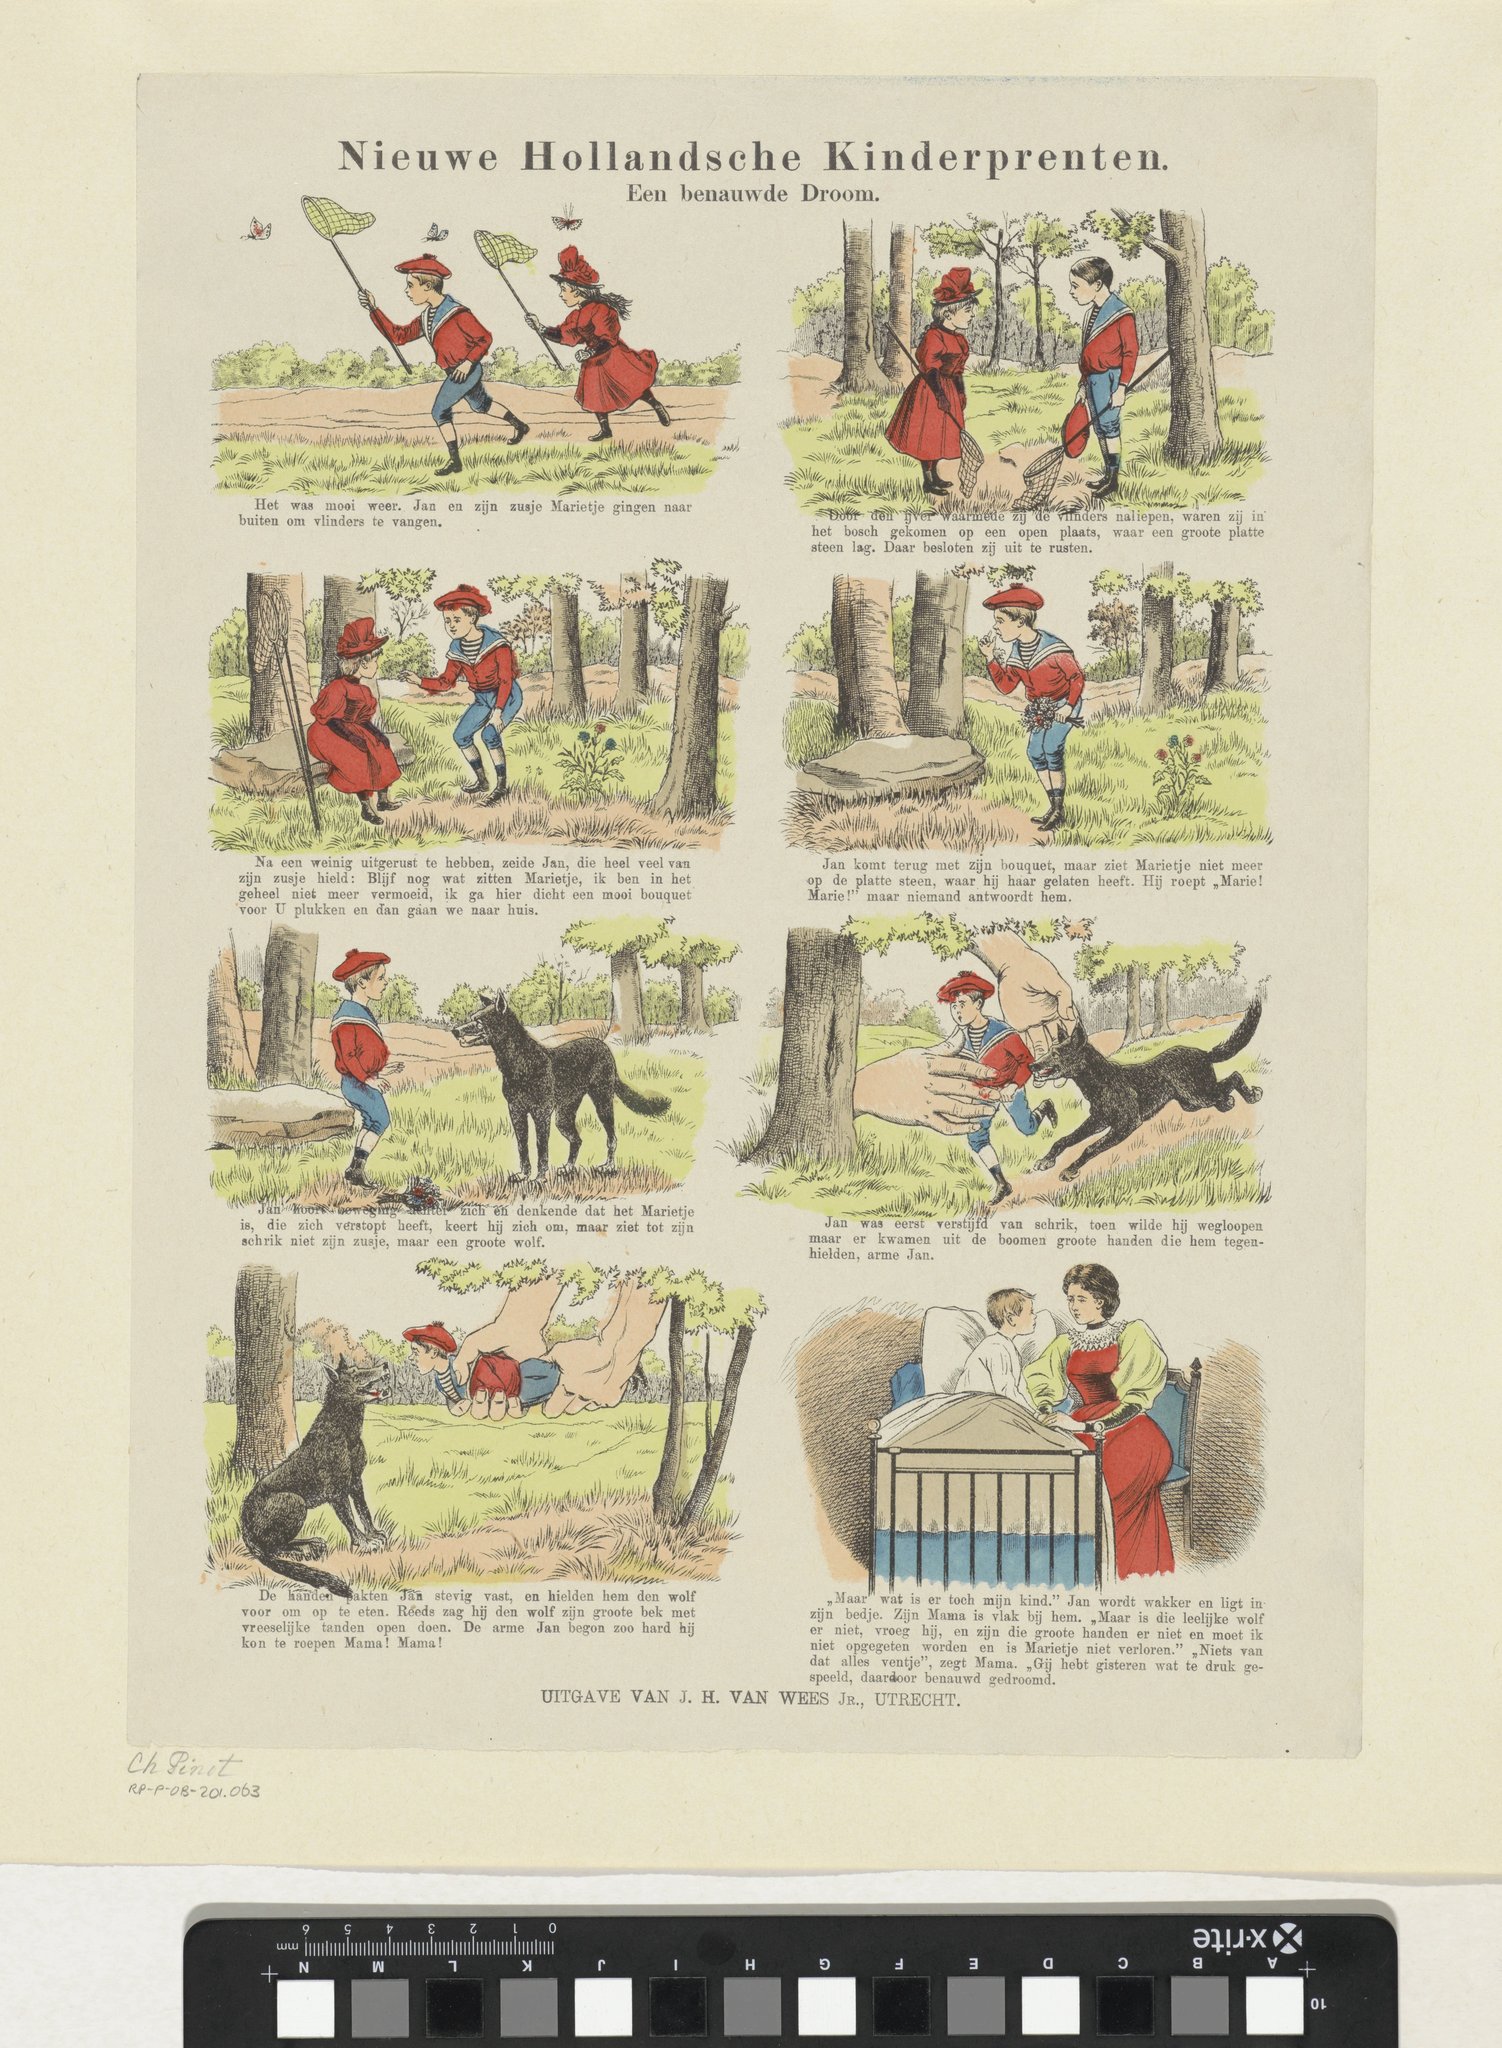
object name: popular print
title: Nieuwe Hollandsche kinderprenten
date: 1869-1888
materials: paper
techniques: colour, letterpress printing, lithograph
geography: europe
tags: child, dream, beasts of prey, predatory animals: wolf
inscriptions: collector's mark: Lugt 2760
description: Blad met 8 voorstellingen van de nare droom van het jongetje Jan, waarin hij bijna wordt opgegeten door een wolf. Onder elke afbeelding een onderschrift.